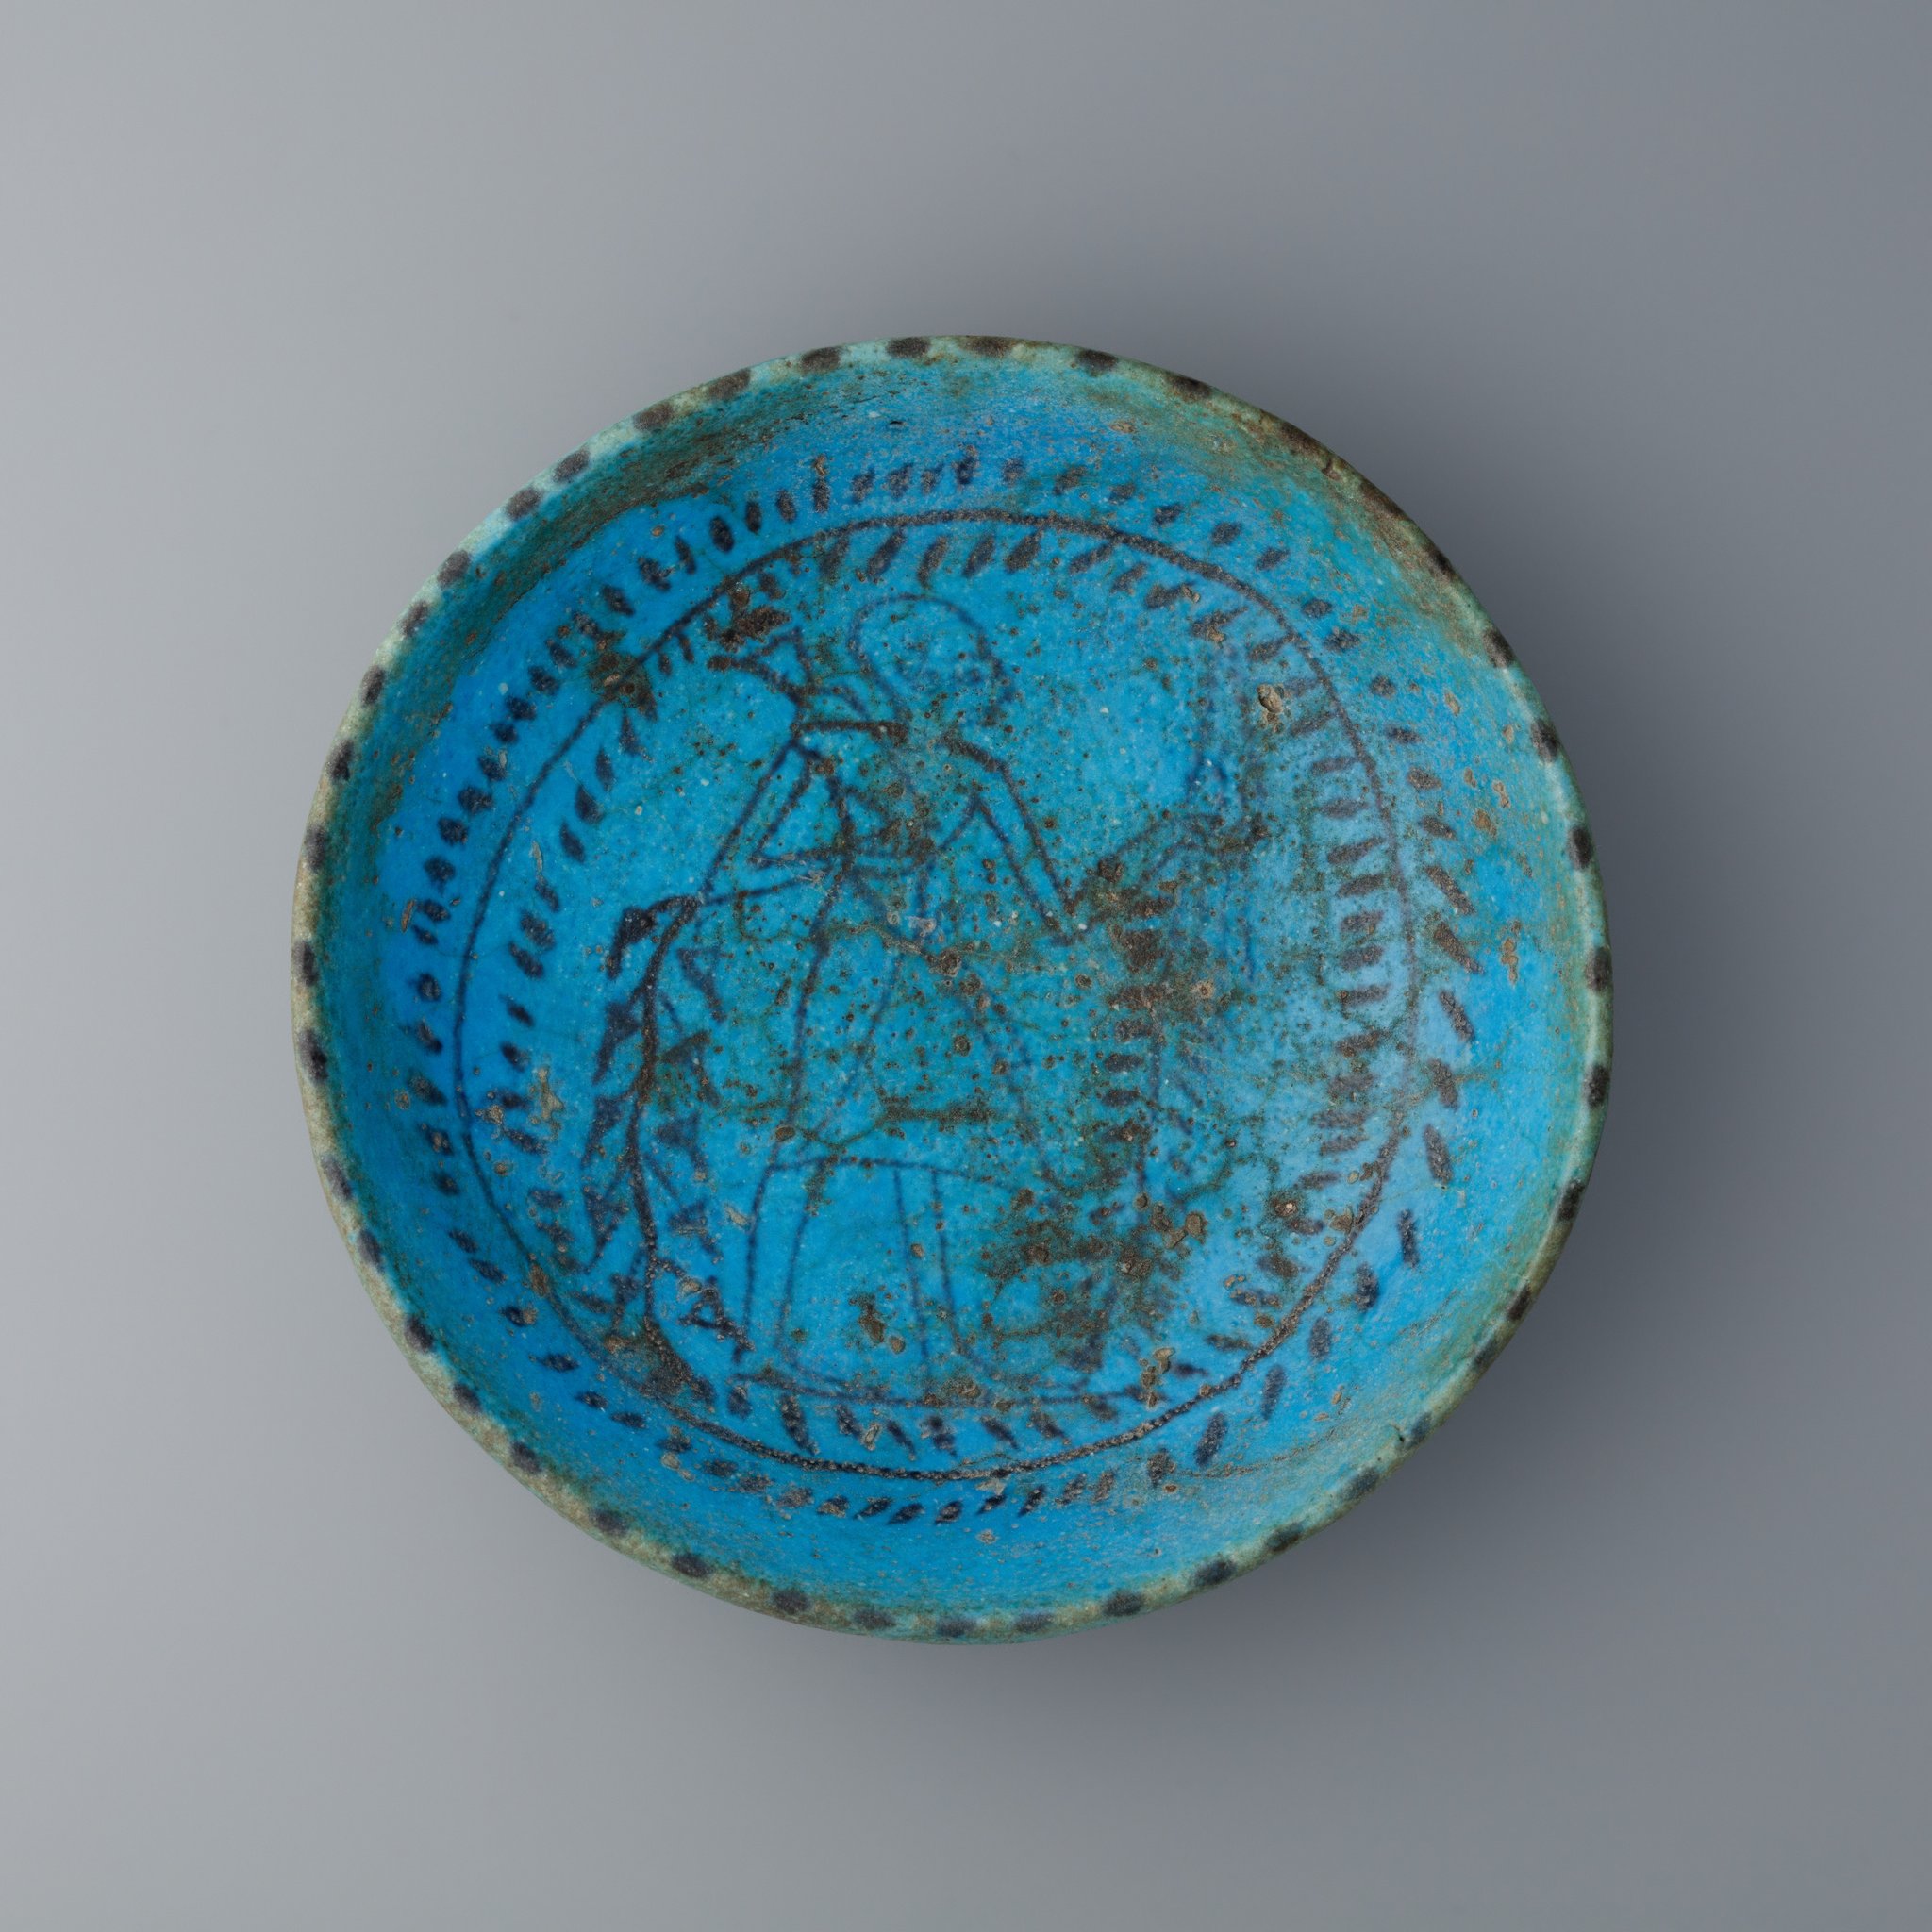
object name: bowl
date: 1295-1185 BCE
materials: faience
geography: egypt